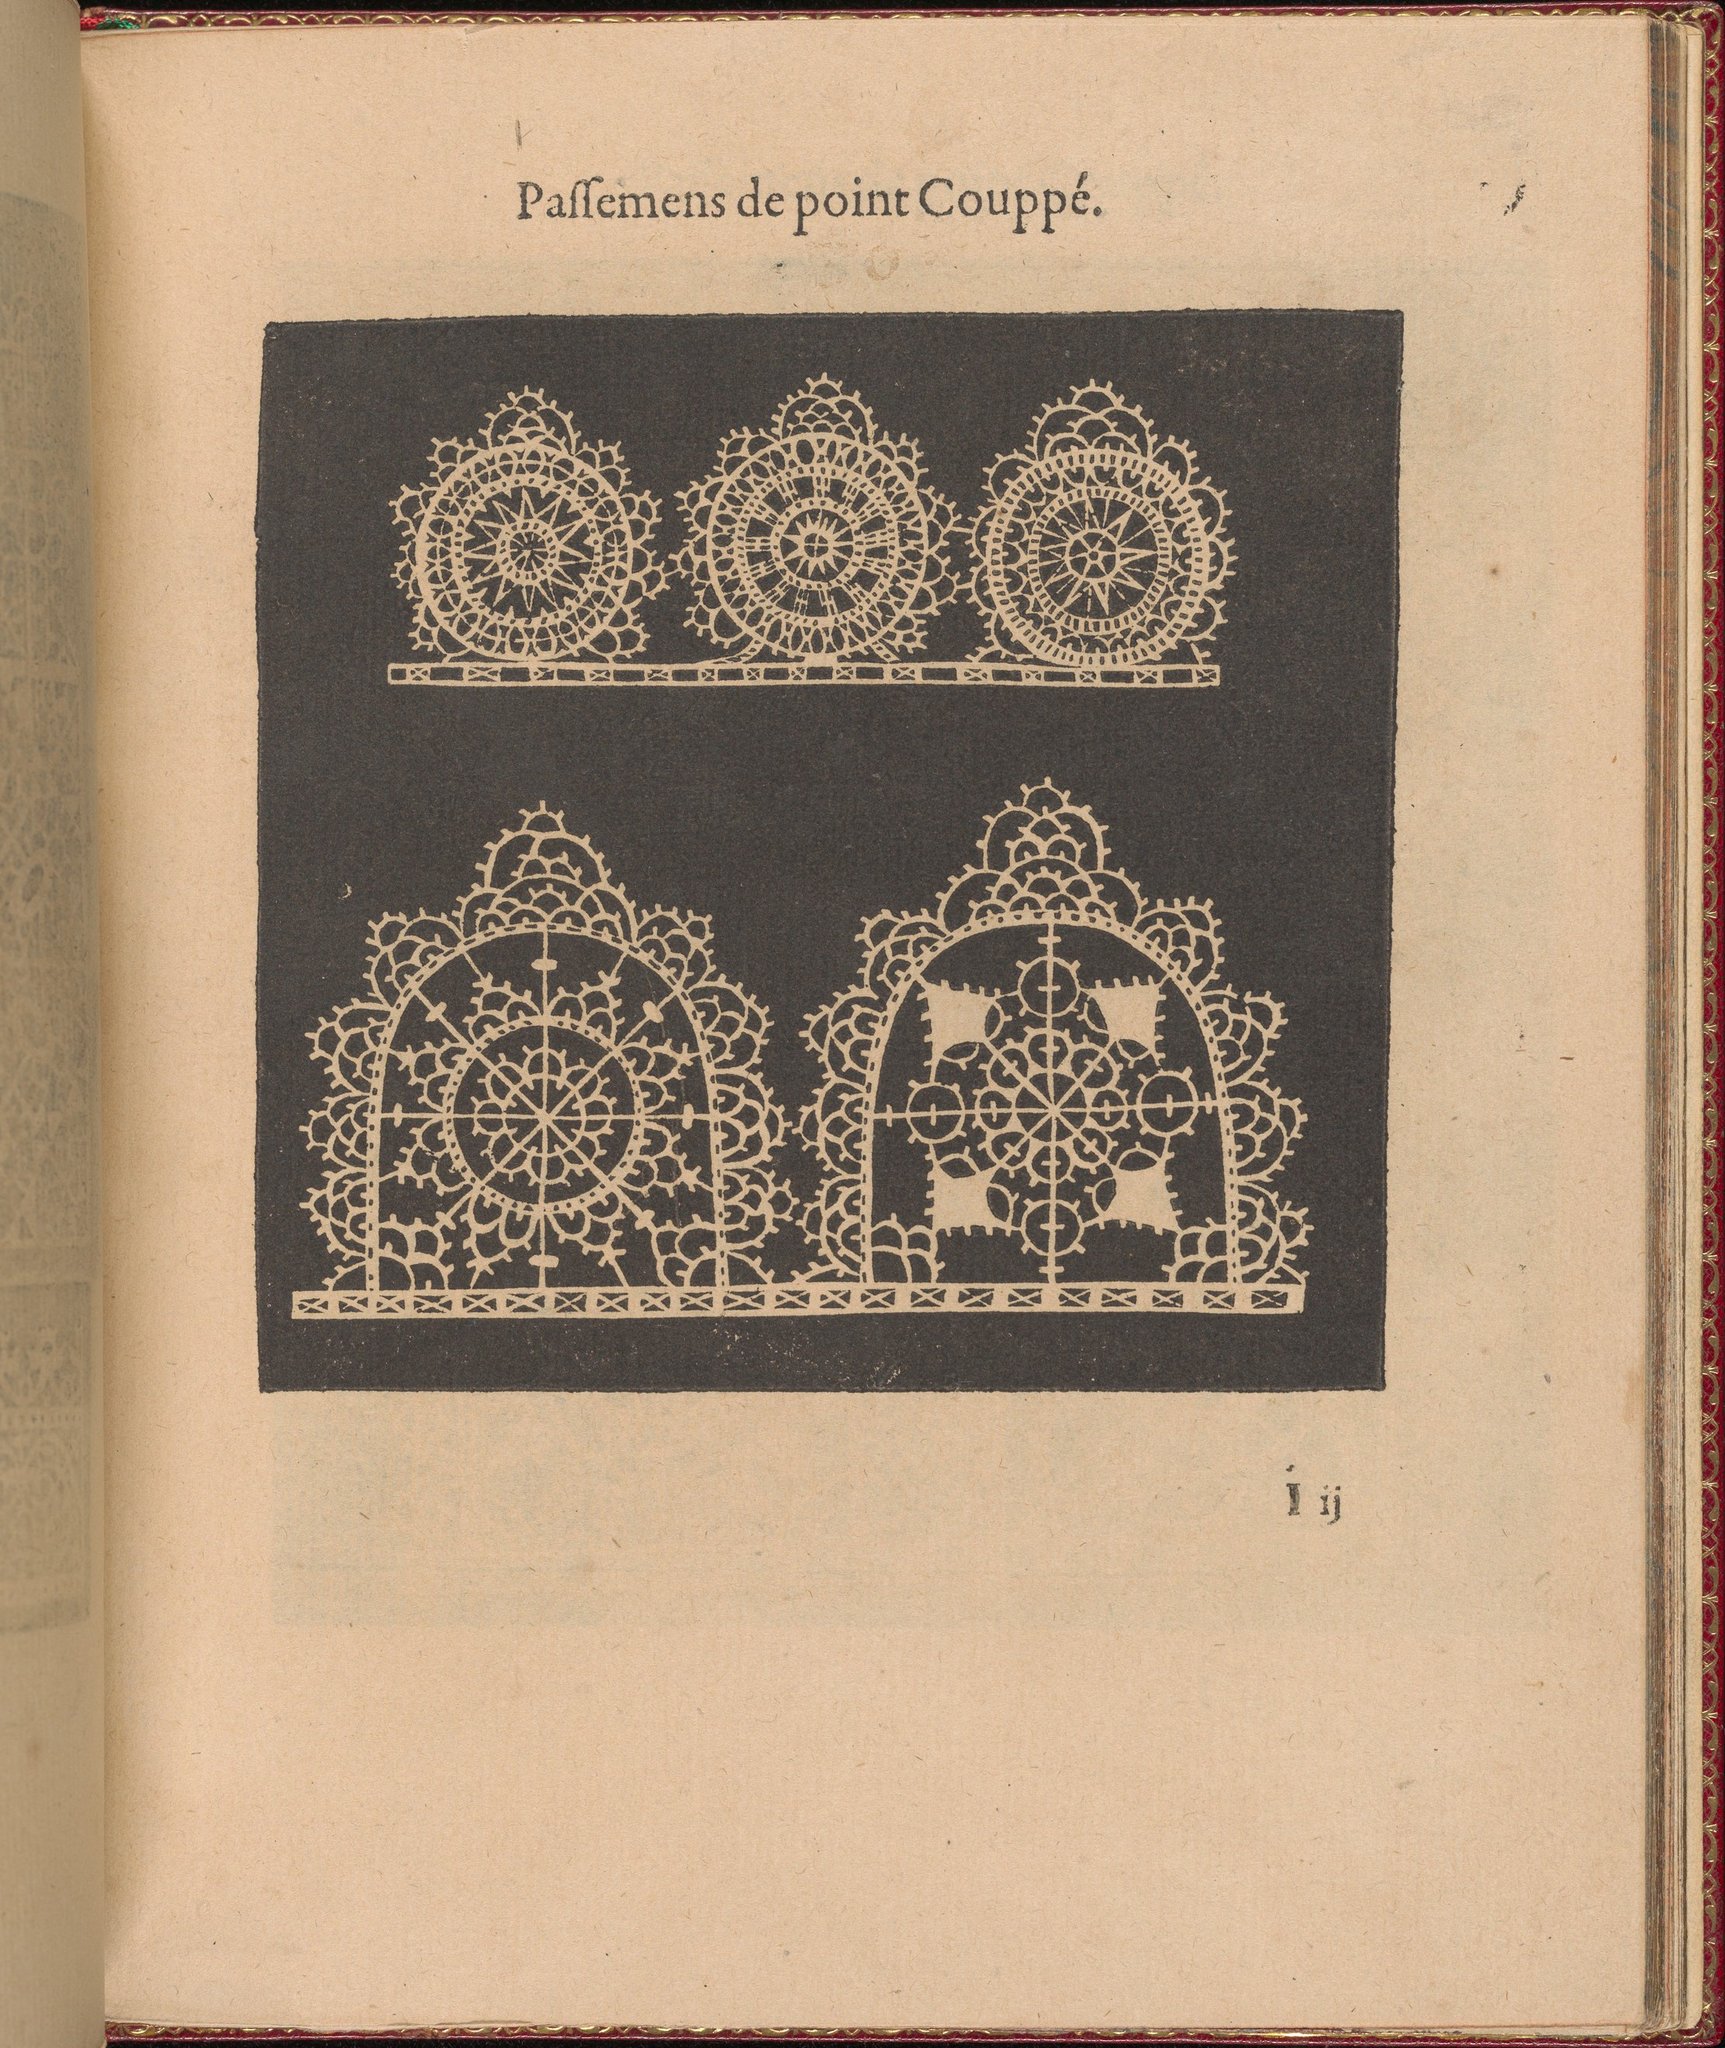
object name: book print ornament architecture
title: Les Singuliers et Nouveaux Portraicts... page 34 (recto)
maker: federico de vinciolo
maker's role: designer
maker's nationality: italian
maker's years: 1582-1599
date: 1588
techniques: woodcut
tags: ornament